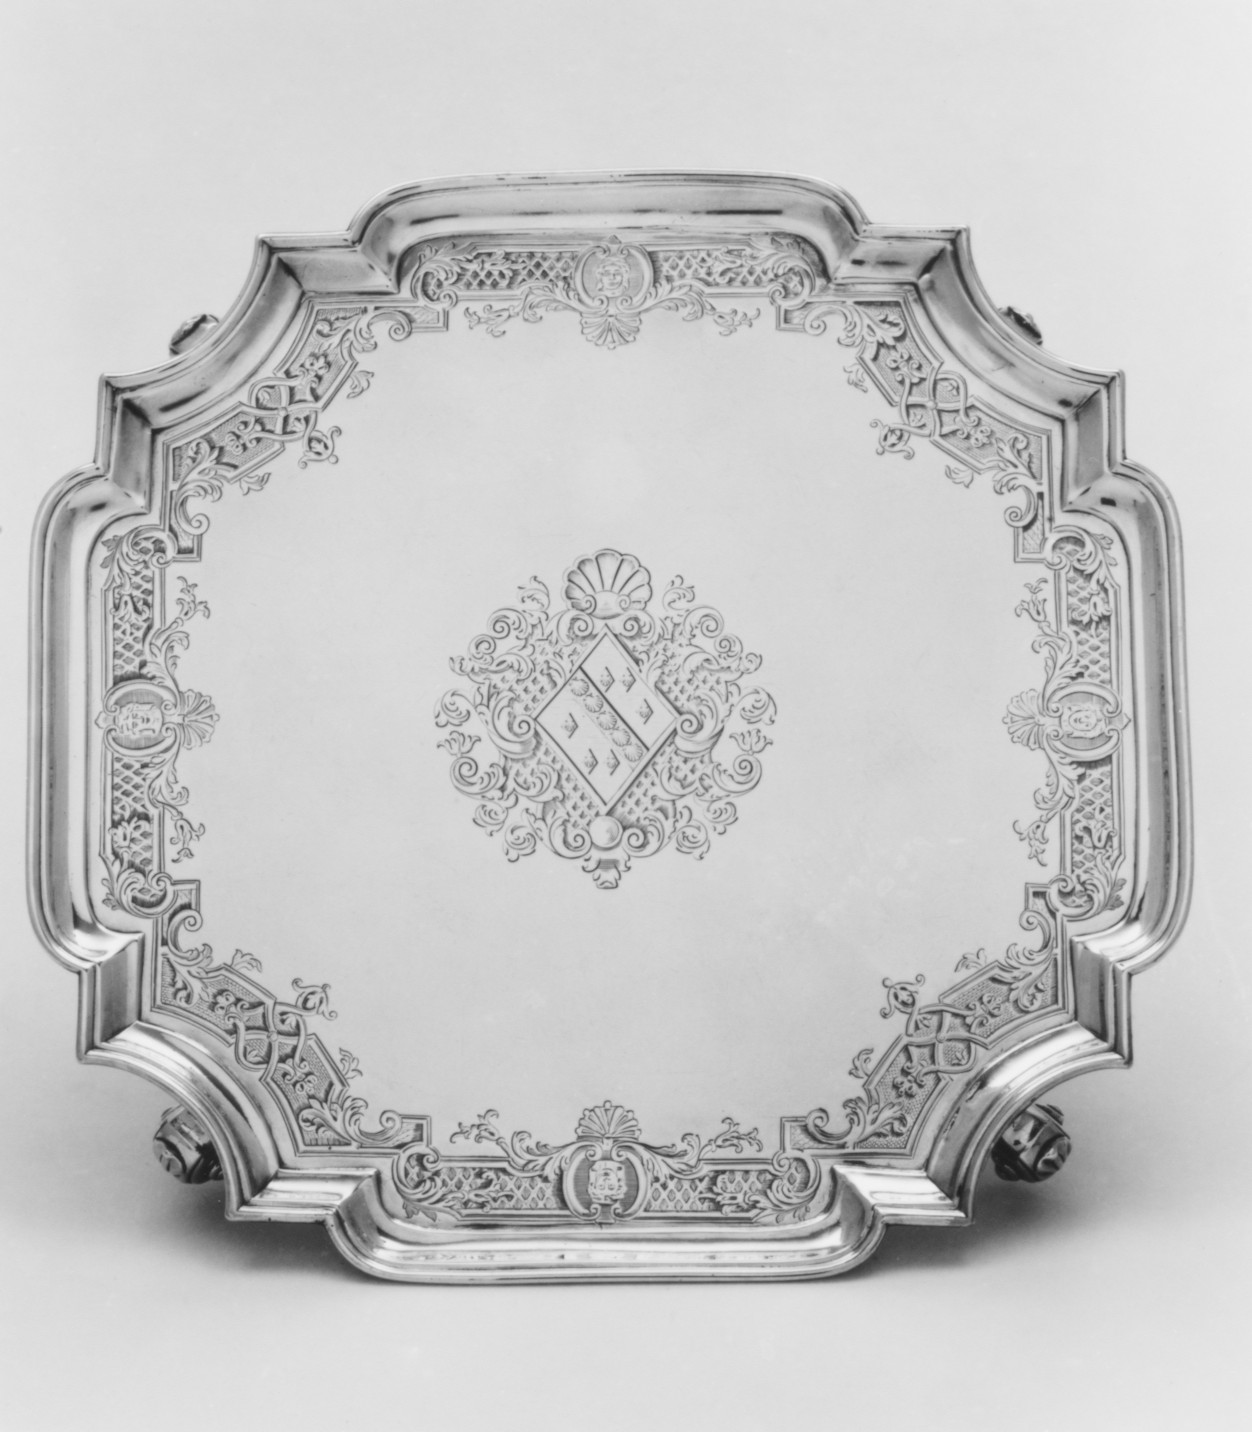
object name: salver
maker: george hindmarsh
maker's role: maker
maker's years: 1731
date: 1733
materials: silver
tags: coat of arms